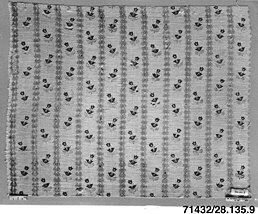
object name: piece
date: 1767-1800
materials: cotton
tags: flowers